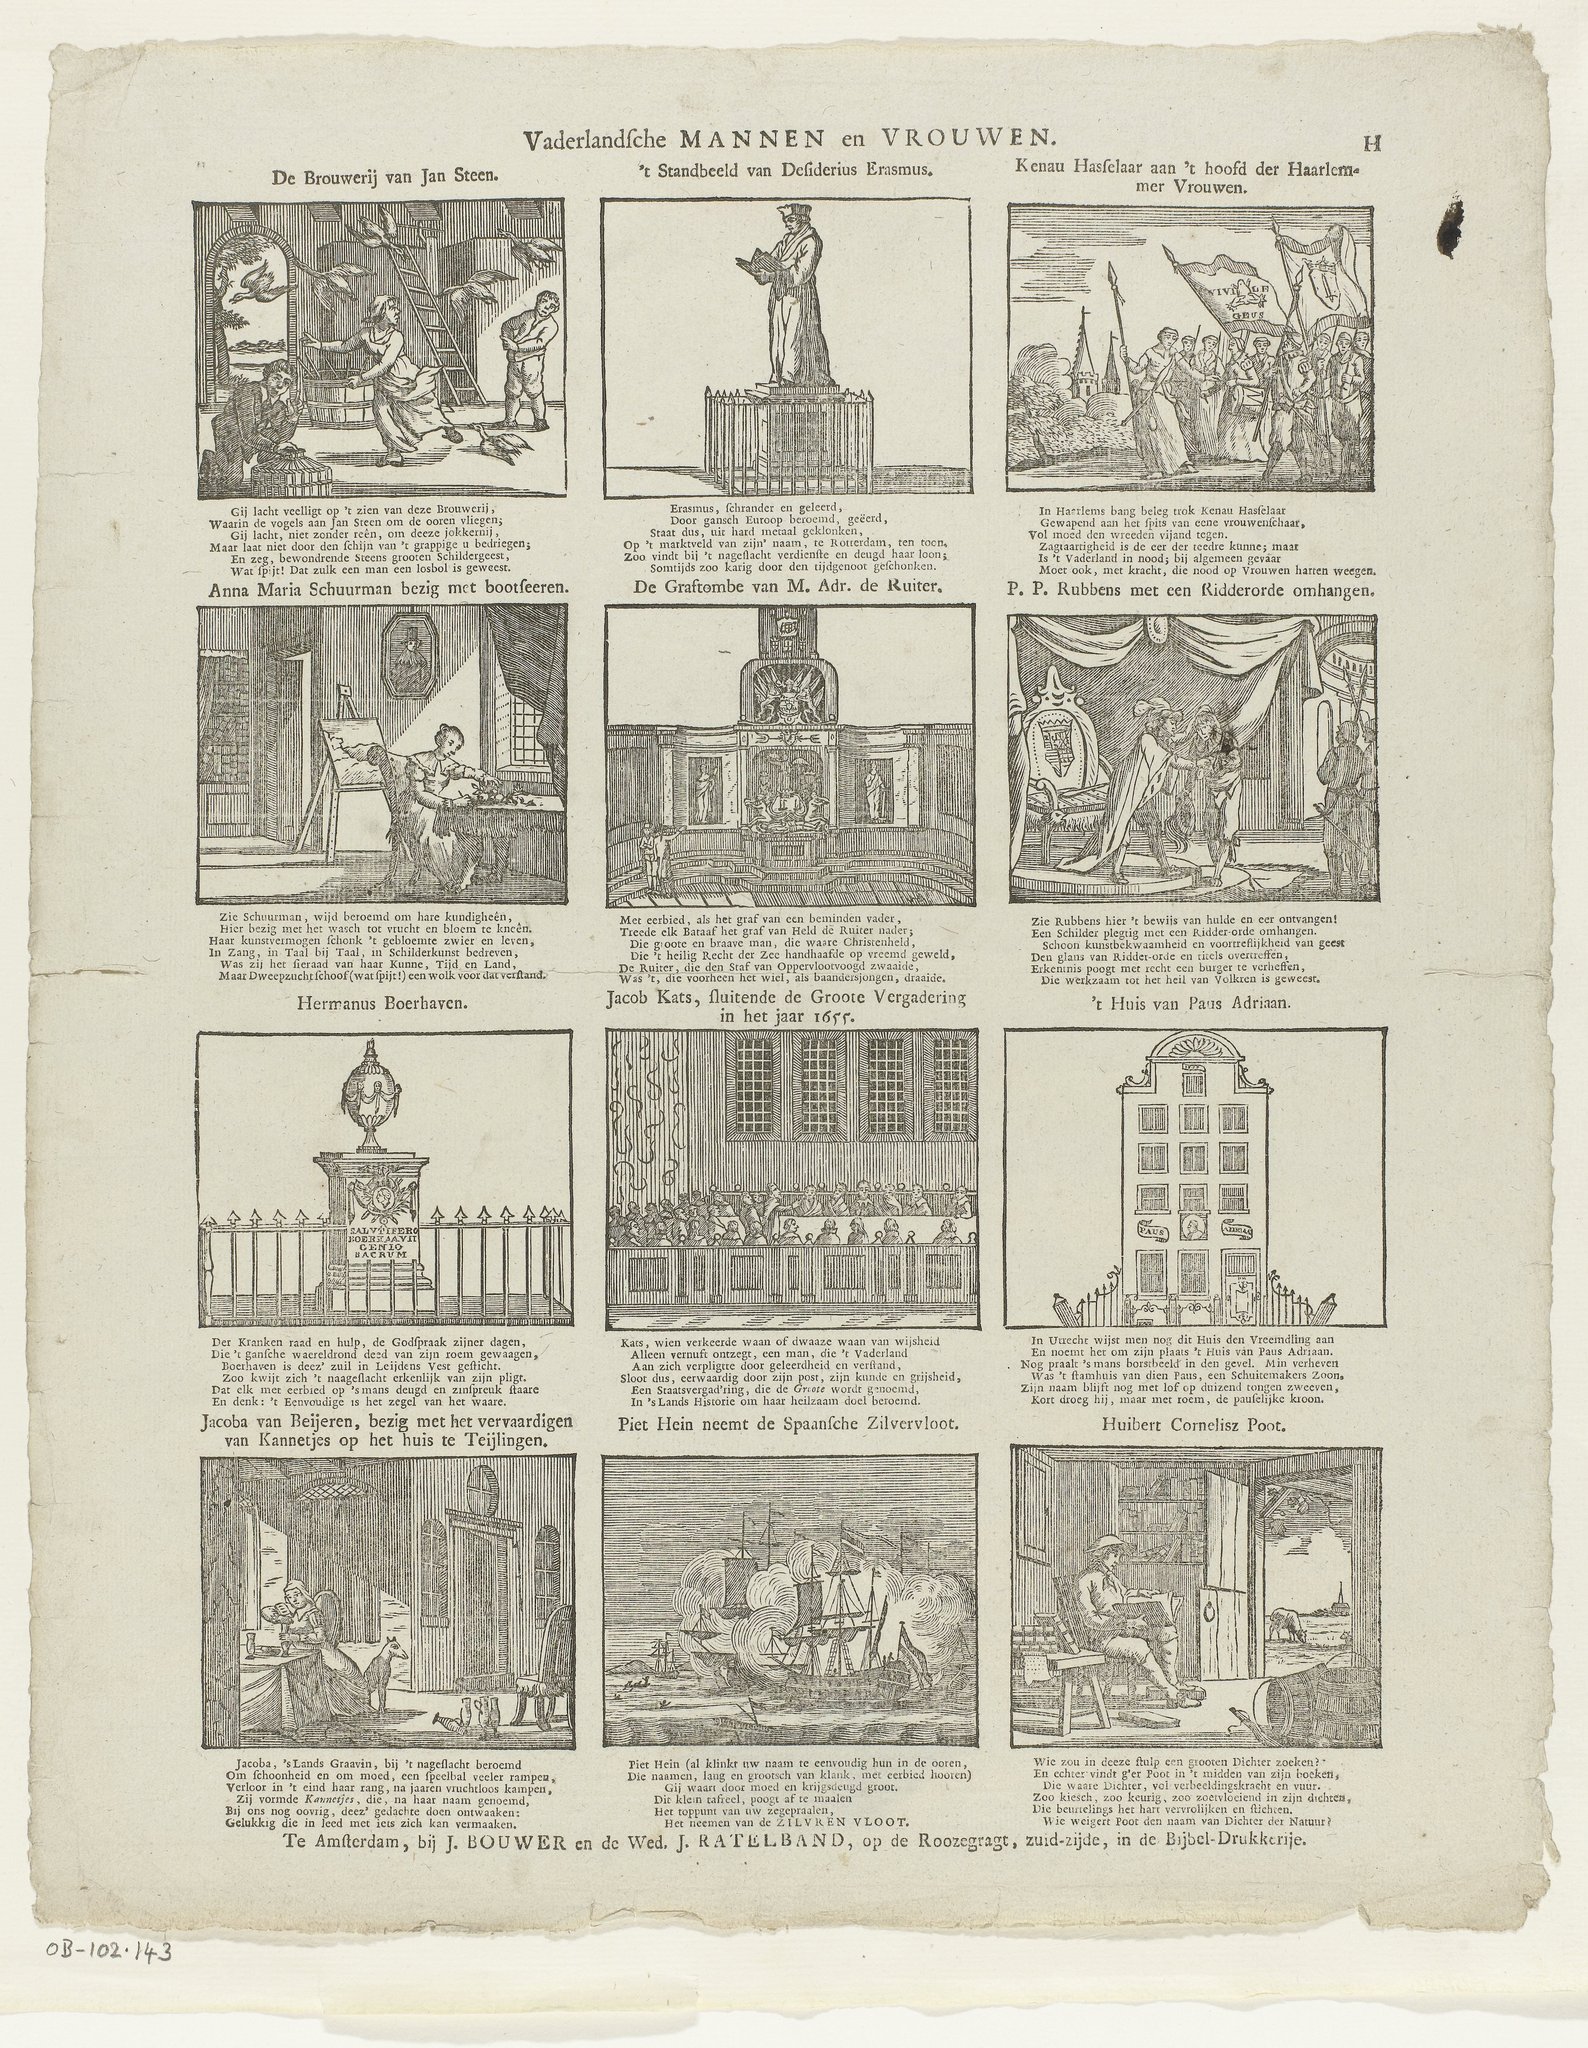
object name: popular print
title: Vaderlandsche mannen en vrouwen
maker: Anonymous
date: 1794-1804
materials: paper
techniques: letterpress printing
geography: amsterdam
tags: cologne, anna maria van schurman, jan havicksz. steen, jacoba of bavaria (countess of hainaut), rotterdam, desiderius erasmus, flushing, michiel adriaenszoon de ruyter, delfshaven, the hague, jacob cats (1577-1660), delft, hubert kornelisz. poot, antwerp, painter, print maker, draughtsman, peter paul rubens, utrecht, leiden, hermanus boerhaave, coin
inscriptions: collector's mark: Lugt 2760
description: Blad met 12 voorstellingen van of over beroemde Nederlandse mannen en vrouwen, historische figuren. Boven elke afbeelding een titel, onder elke afbeelding een zesregelig vers. Genummerd rechtsboven: H.